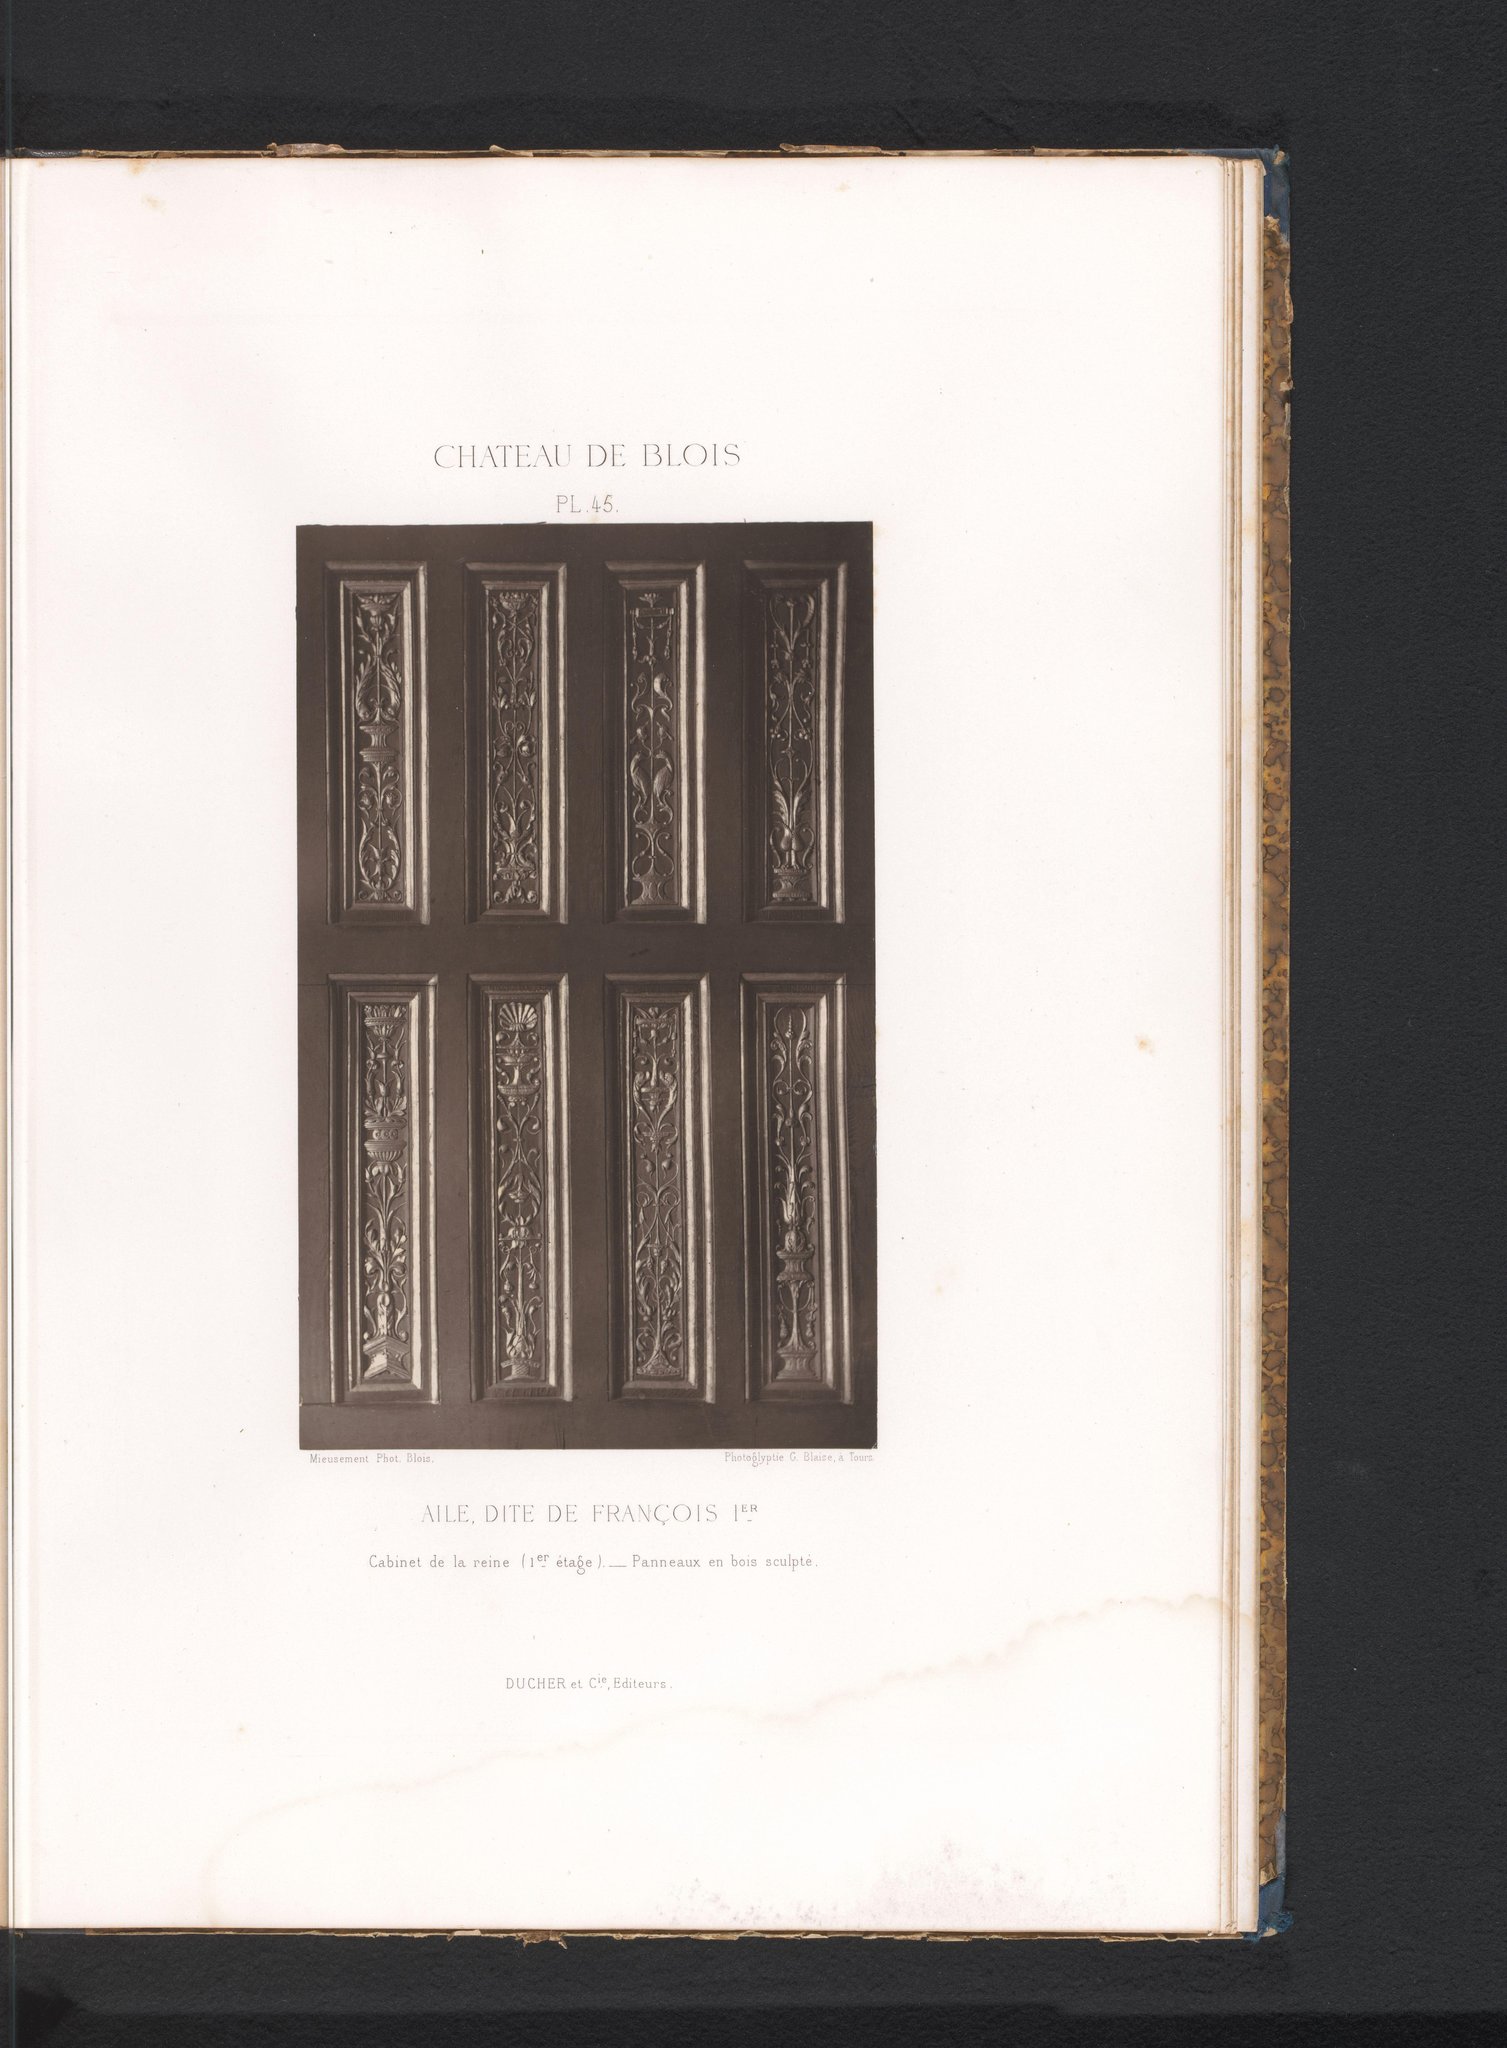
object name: photomechanical print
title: Houten panelen in de Frans I vleugel van het Kasteel van Blois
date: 1870-1875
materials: paper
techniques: woodburytype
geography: tours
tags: panelling, castle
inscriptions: number: ‘PL. 45.’